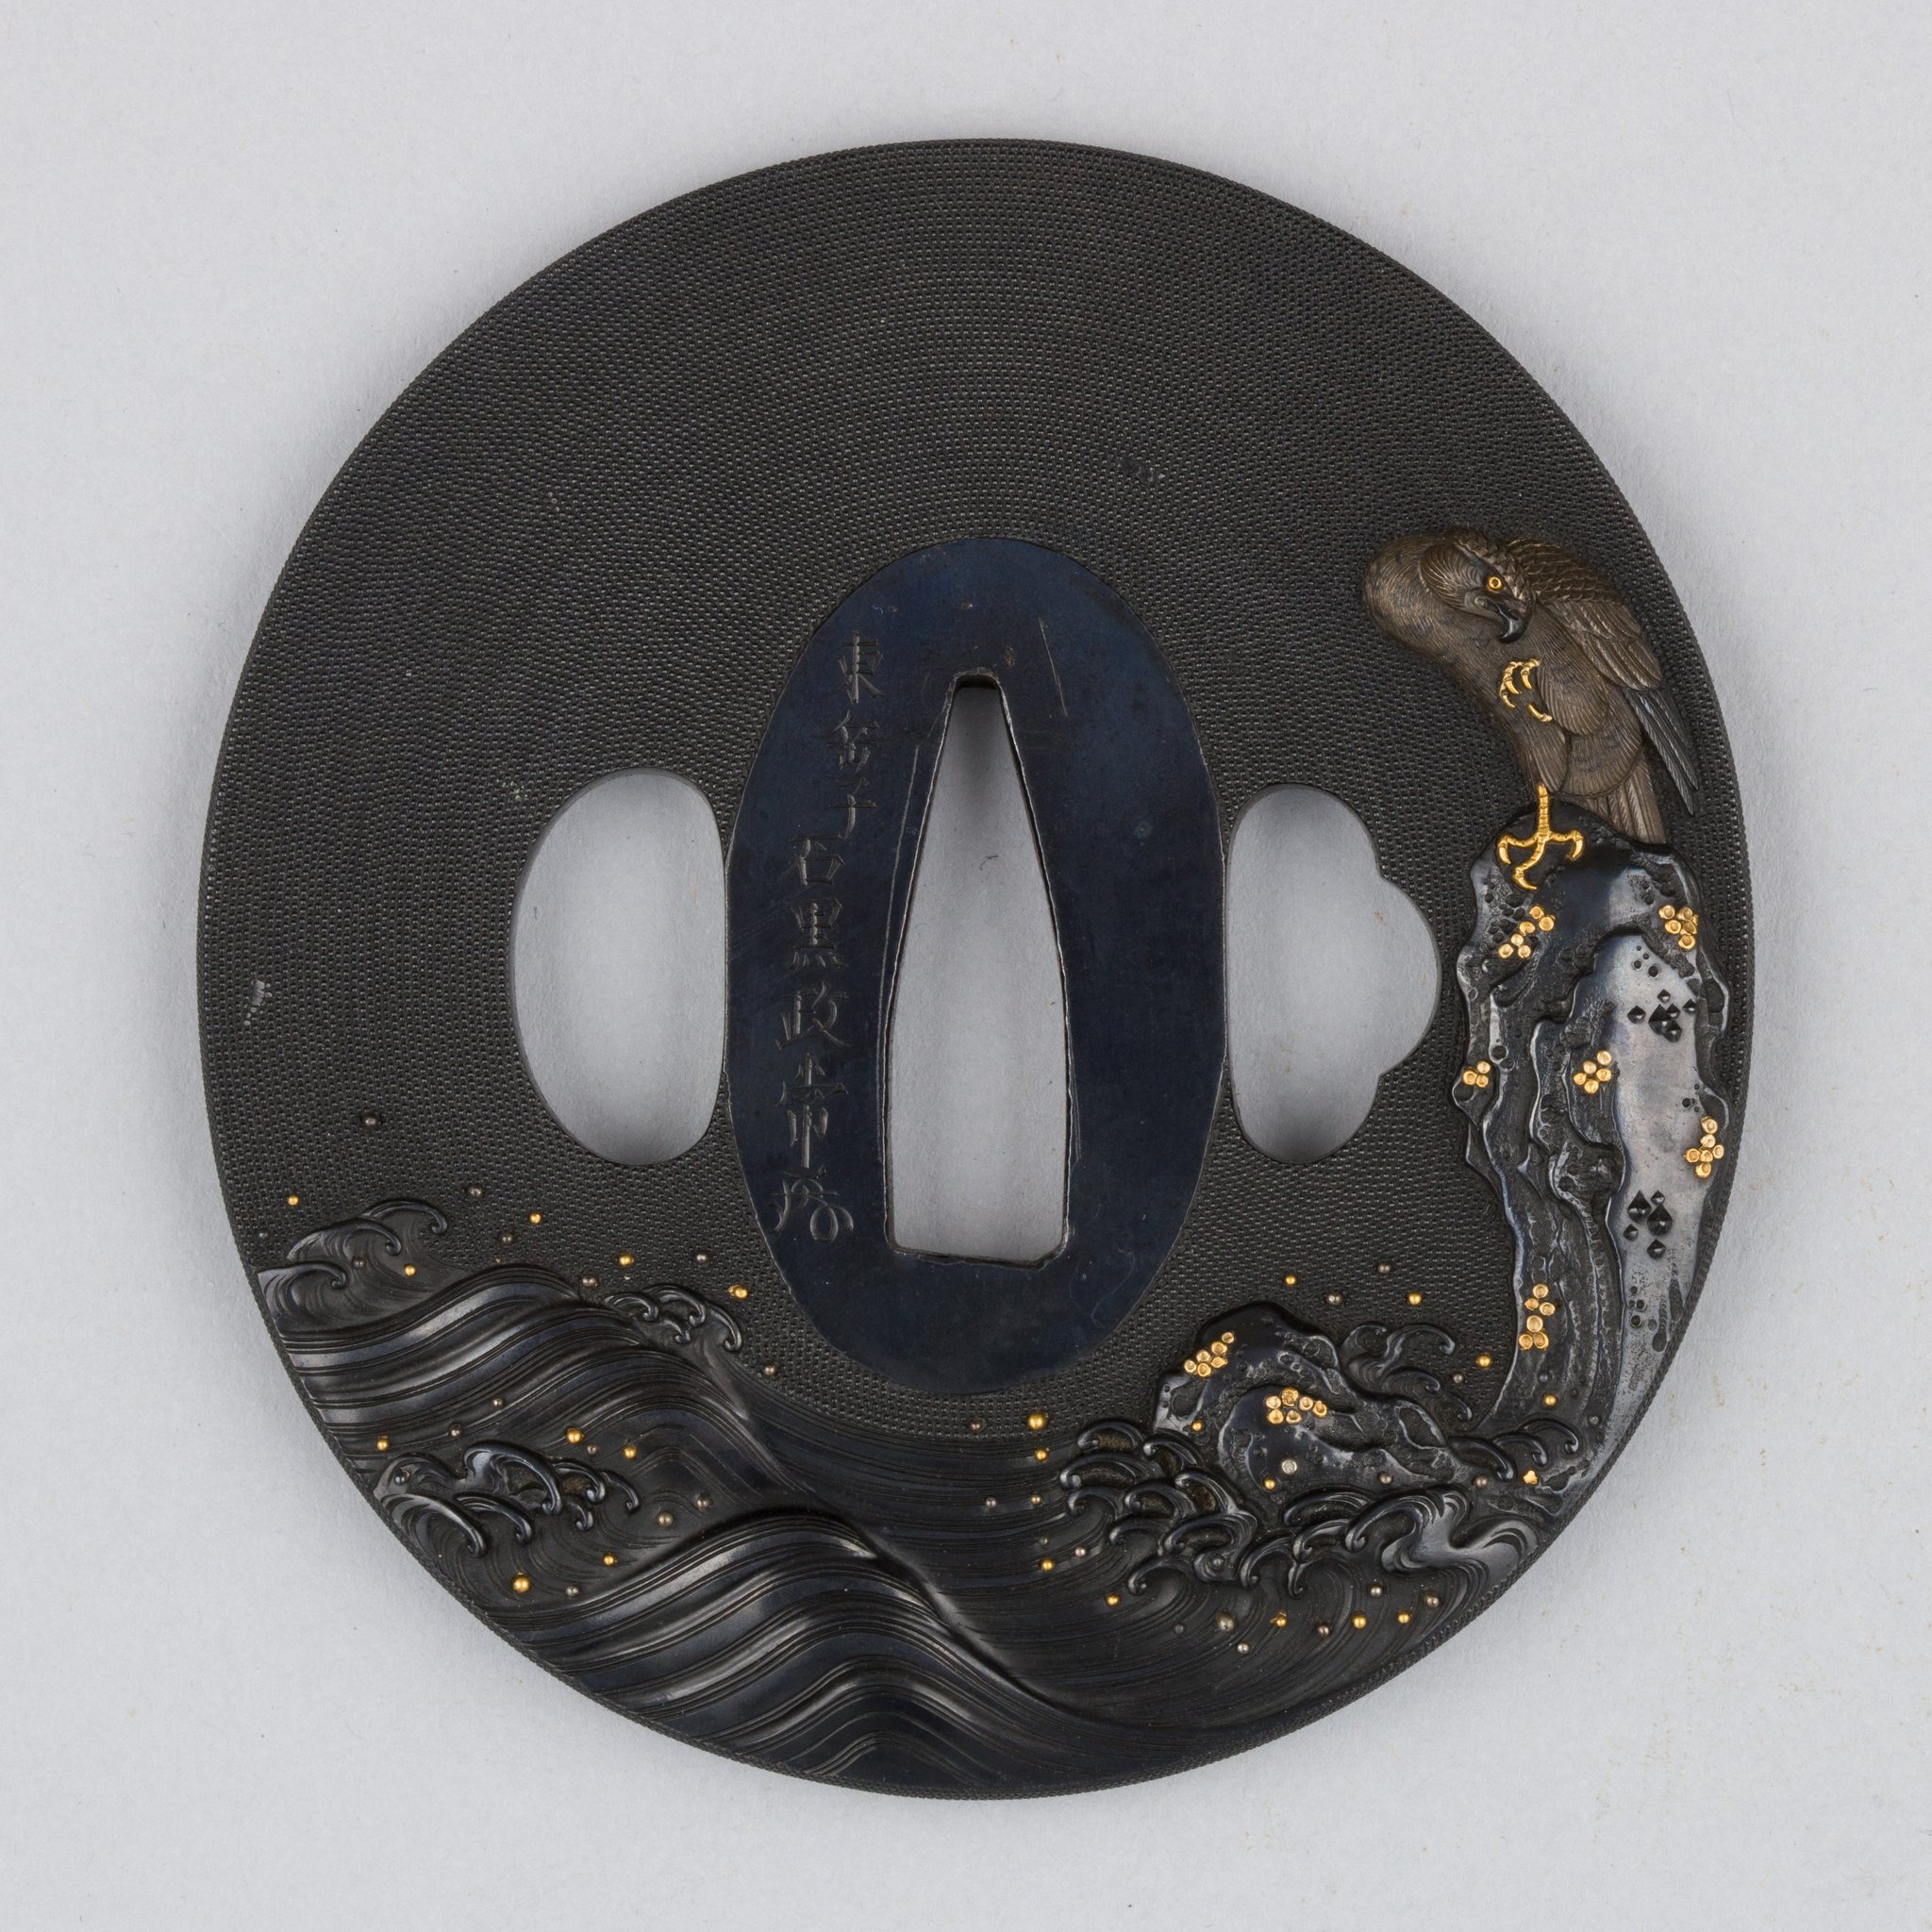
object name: sword guard tsuba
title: 波濤に岩上鷹図大小 Sword Guard (Tsuba)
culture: japanese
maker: 石黒政常 ishiguro masatsune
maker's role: fittings maker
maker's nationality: japanese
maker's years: 1760-1828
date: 1767-1833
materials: copper, gold alloy, silver alloy, gold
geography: japan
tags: birds